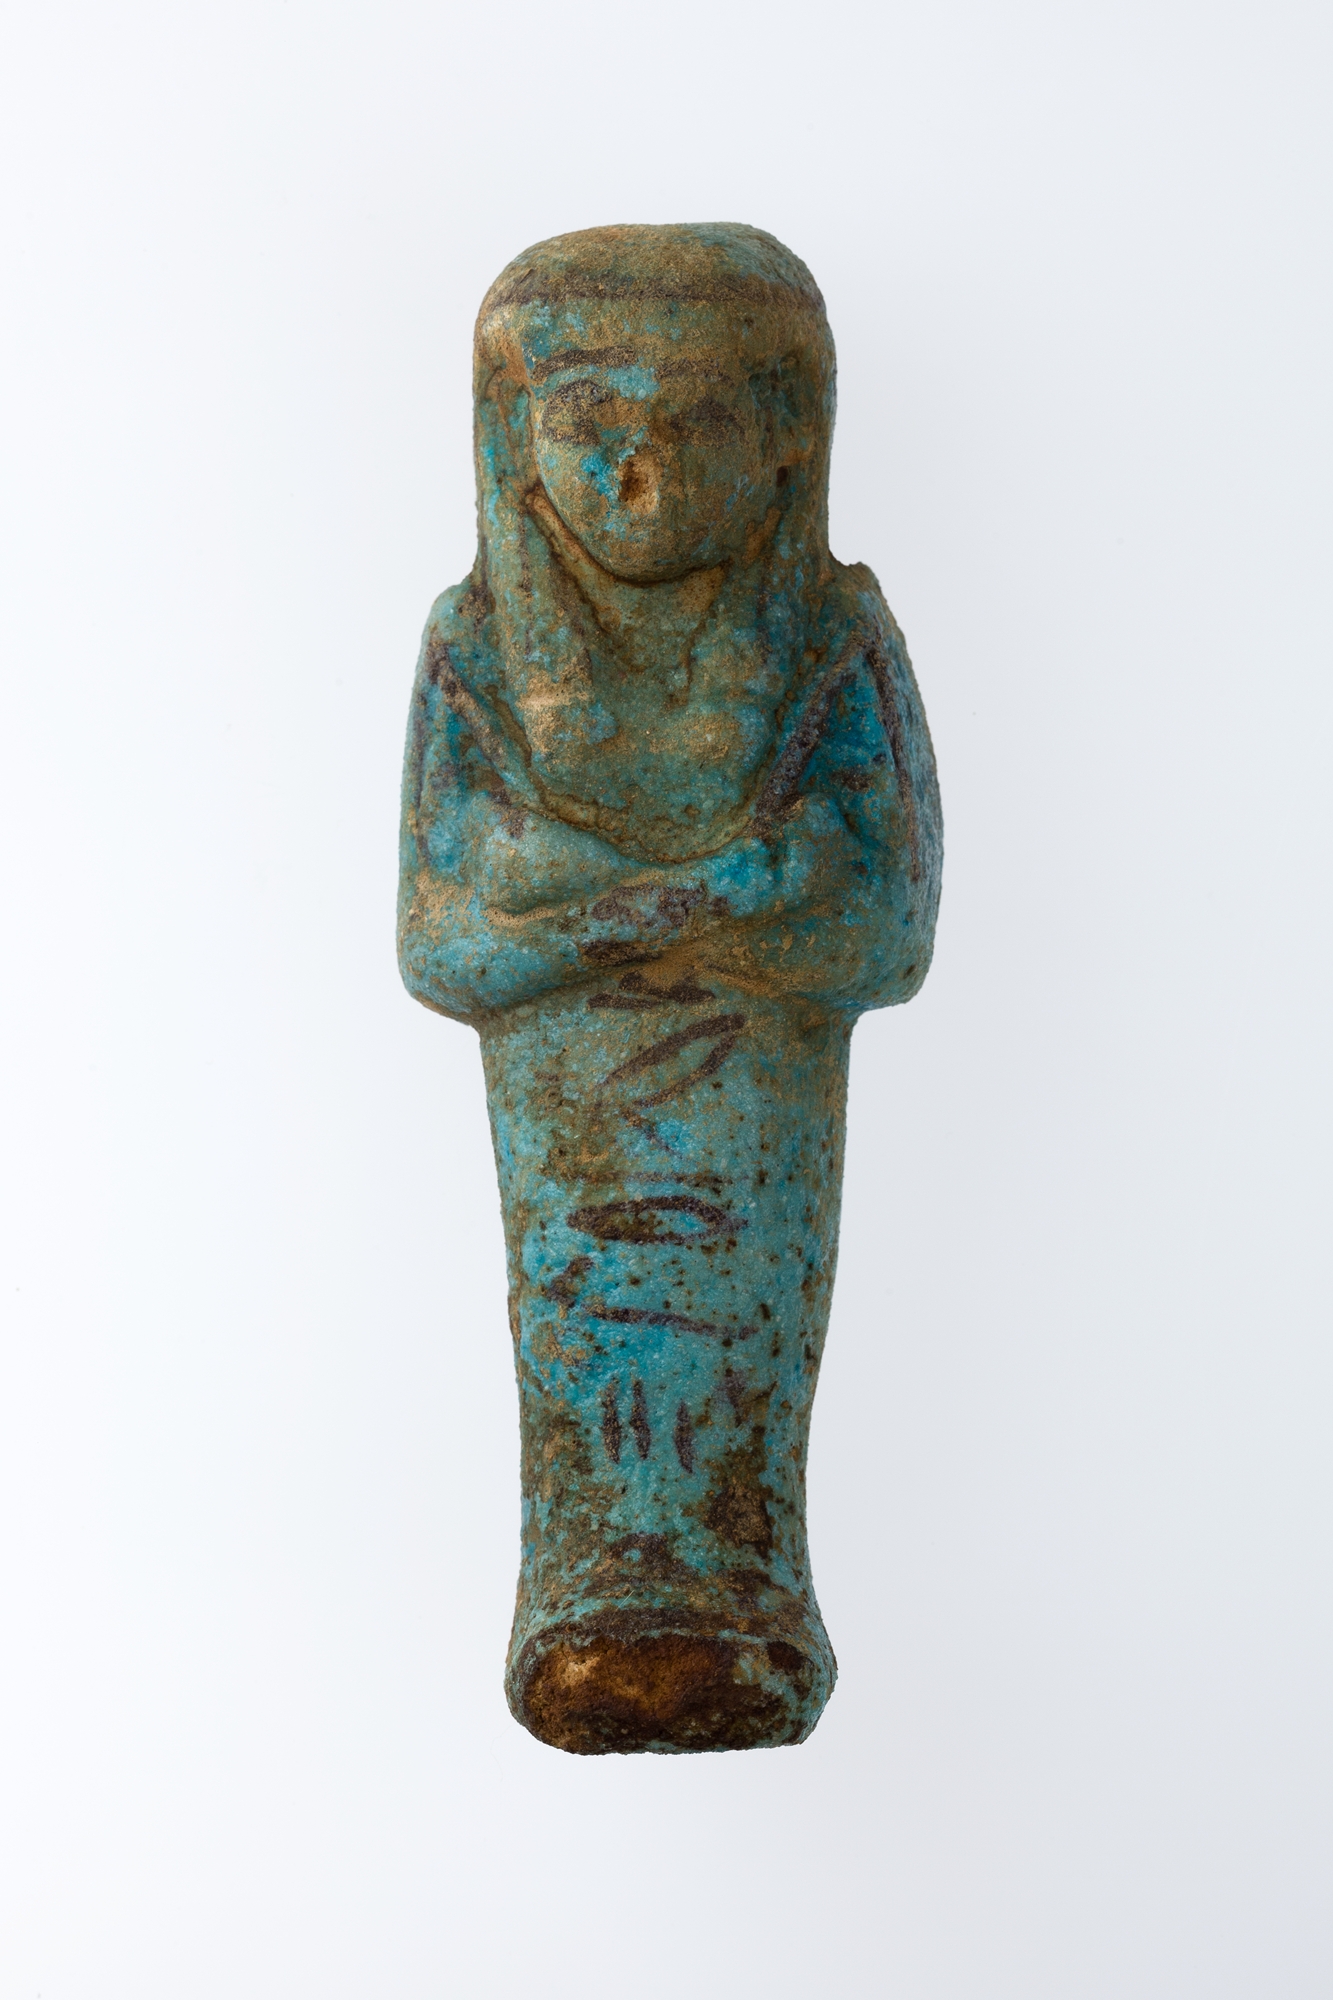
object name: shabti, henettawy c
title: Worker Shabti of Henettawy (C), Daughter of Isetemkheb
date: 990-970 BCE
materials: faience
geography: egypt